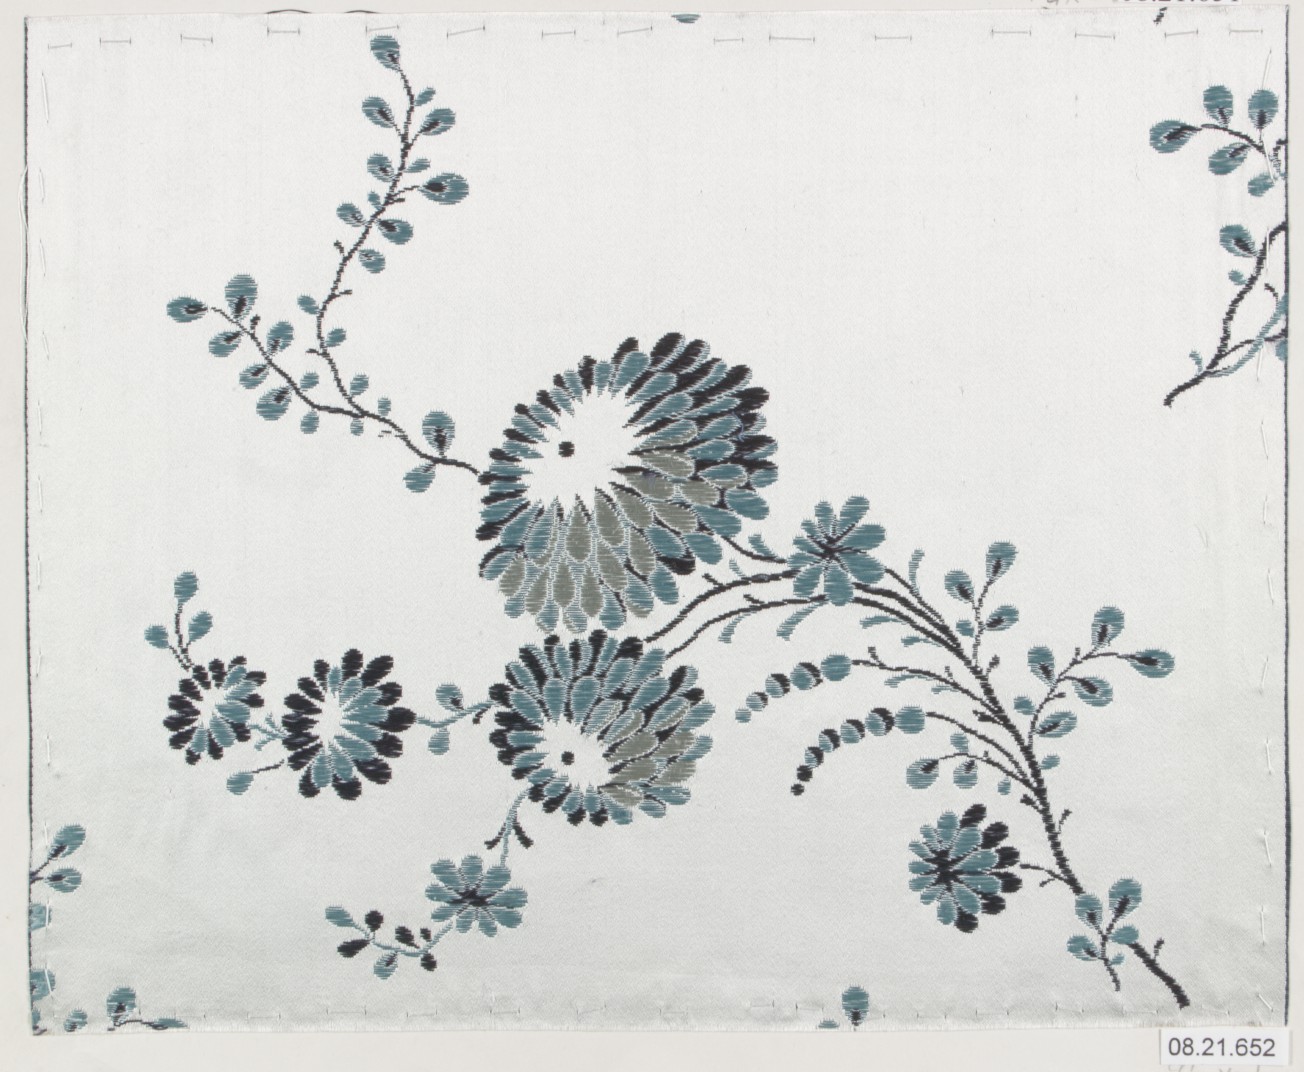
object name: textile sample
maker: Anonymous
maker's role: designer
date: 1900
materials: silk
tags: flowers